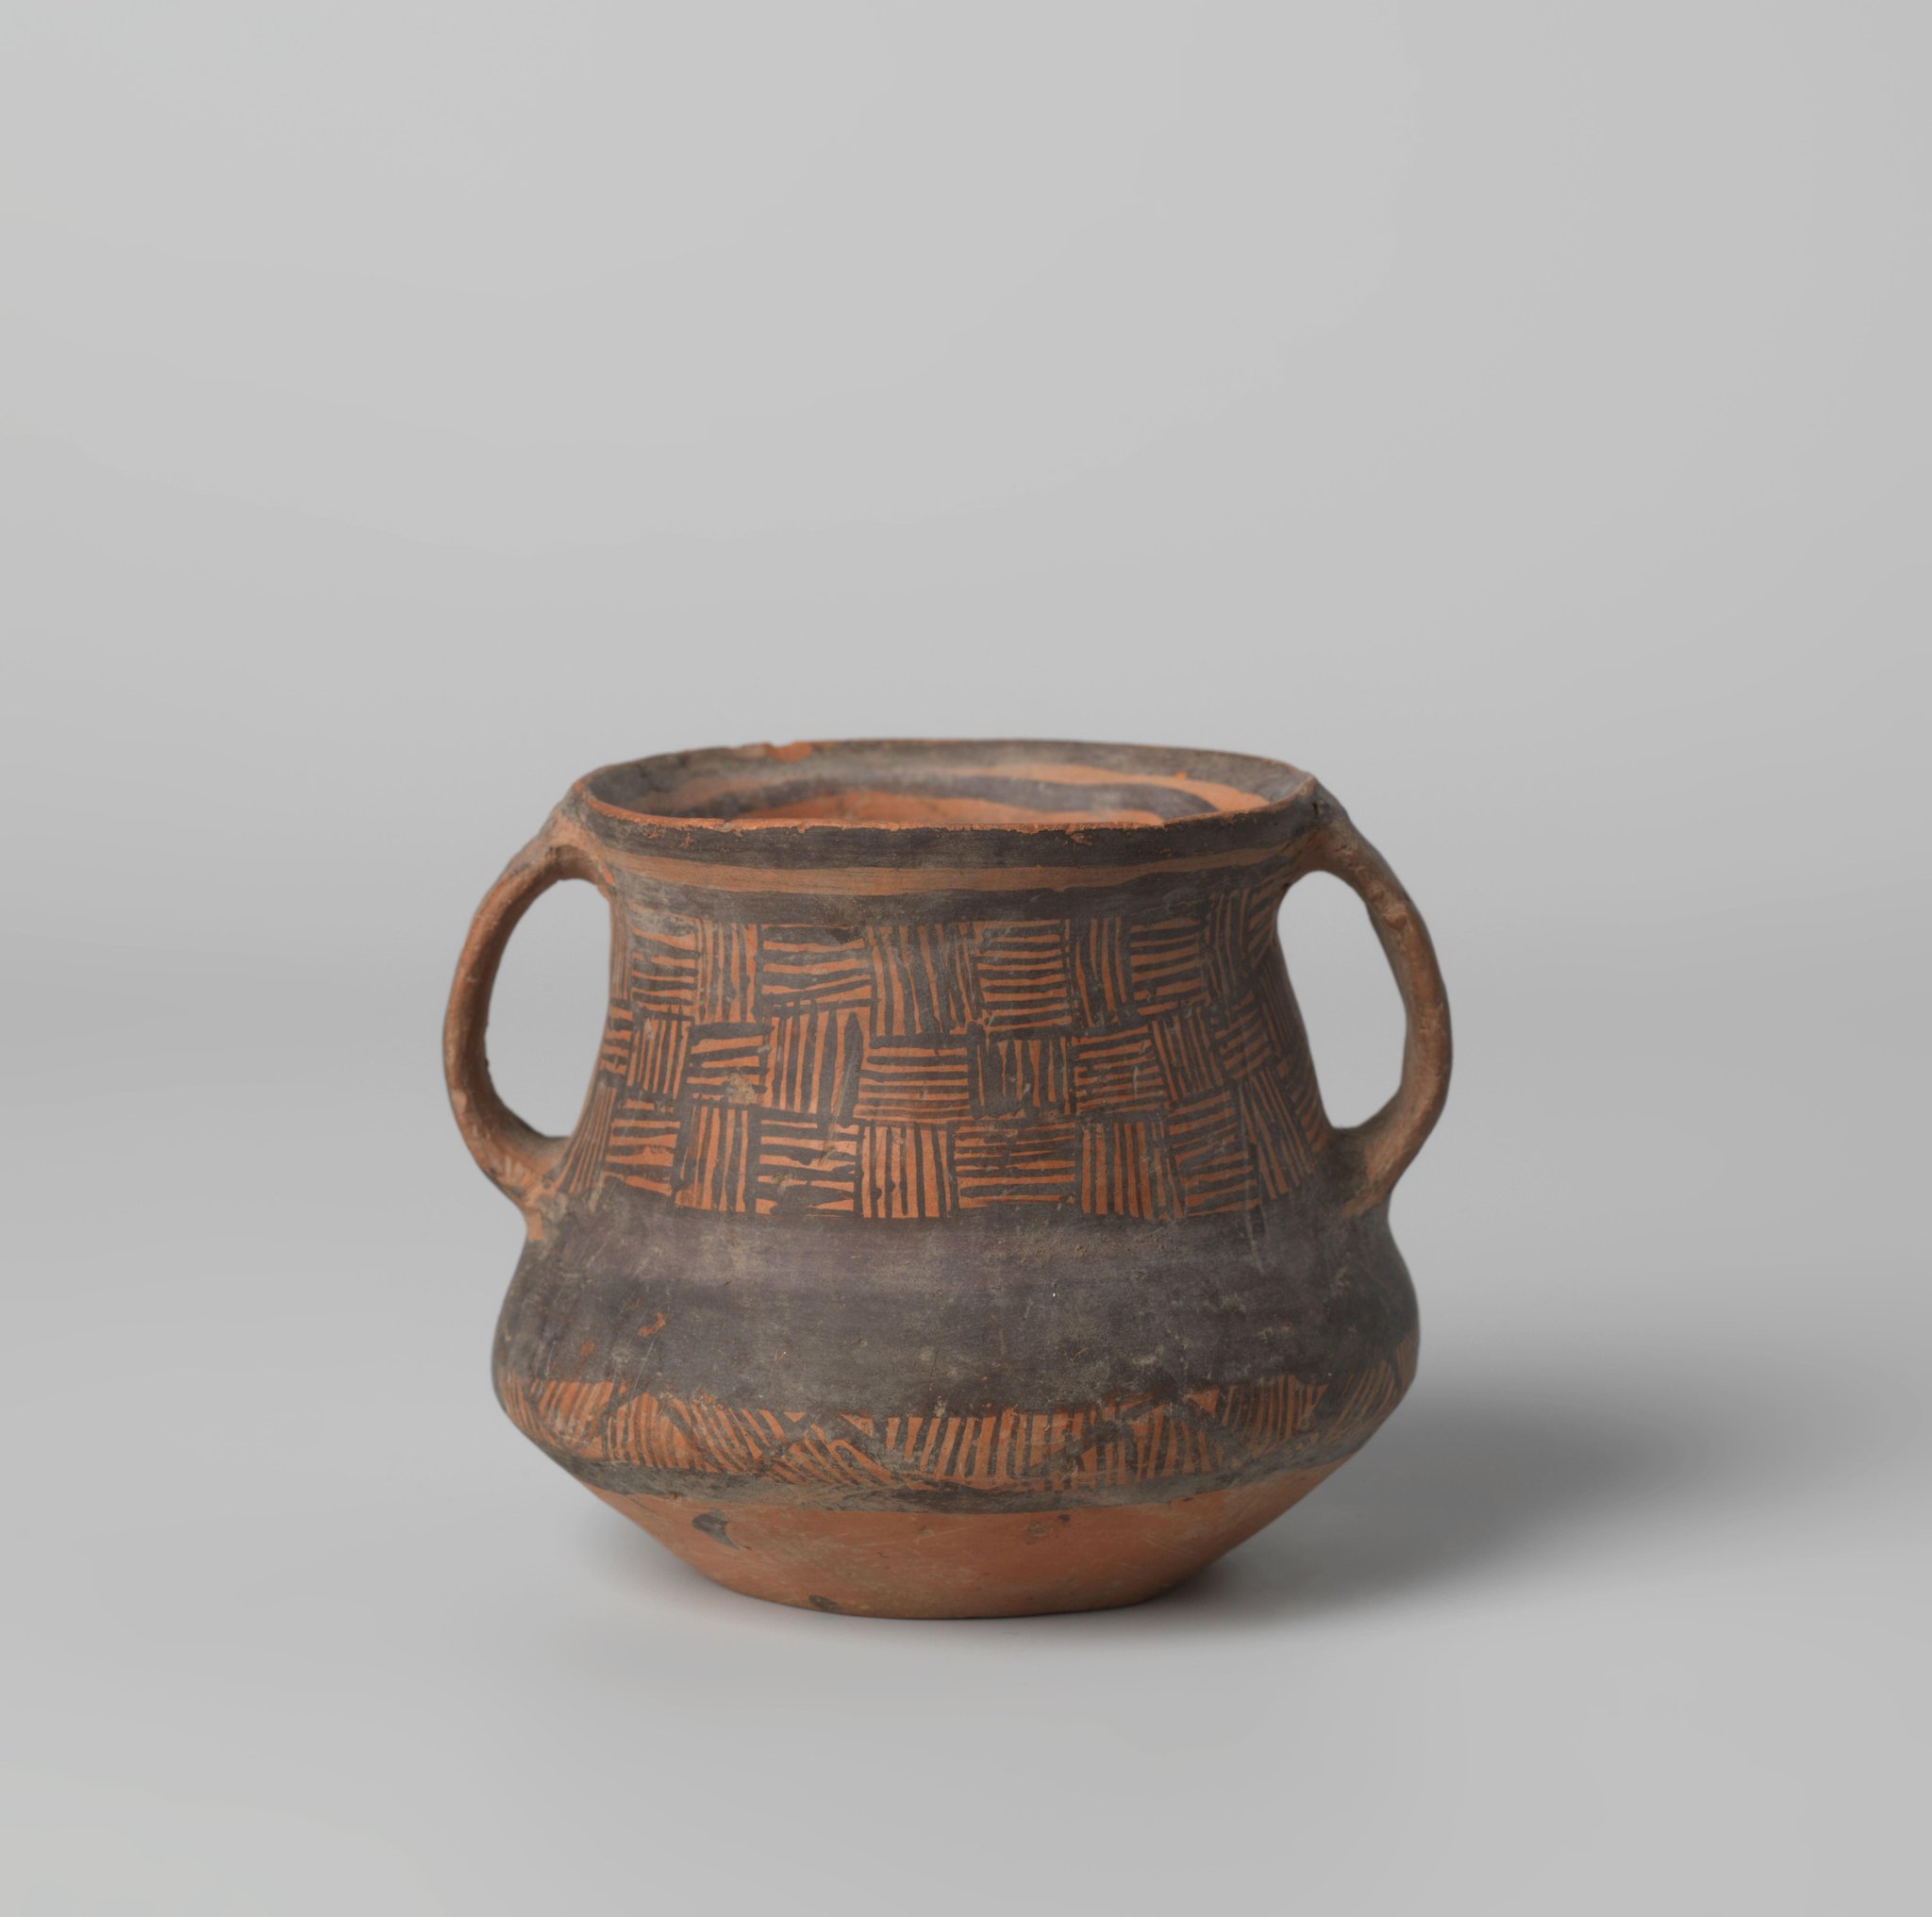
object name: bowl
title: Bowl with two handles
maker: Anonymous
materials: earthenware, paint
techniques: firing, forming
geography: kansu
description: Two Small Jars. Jars such as these usually have a geometrical shape with the elegant lines of the swirling curvilinear pattern decorating the body as a striking detail. The jars were quite often painted while being turned on a pottery wheel. By holding the brush still in one position, the potter could create lines of the same thickness.